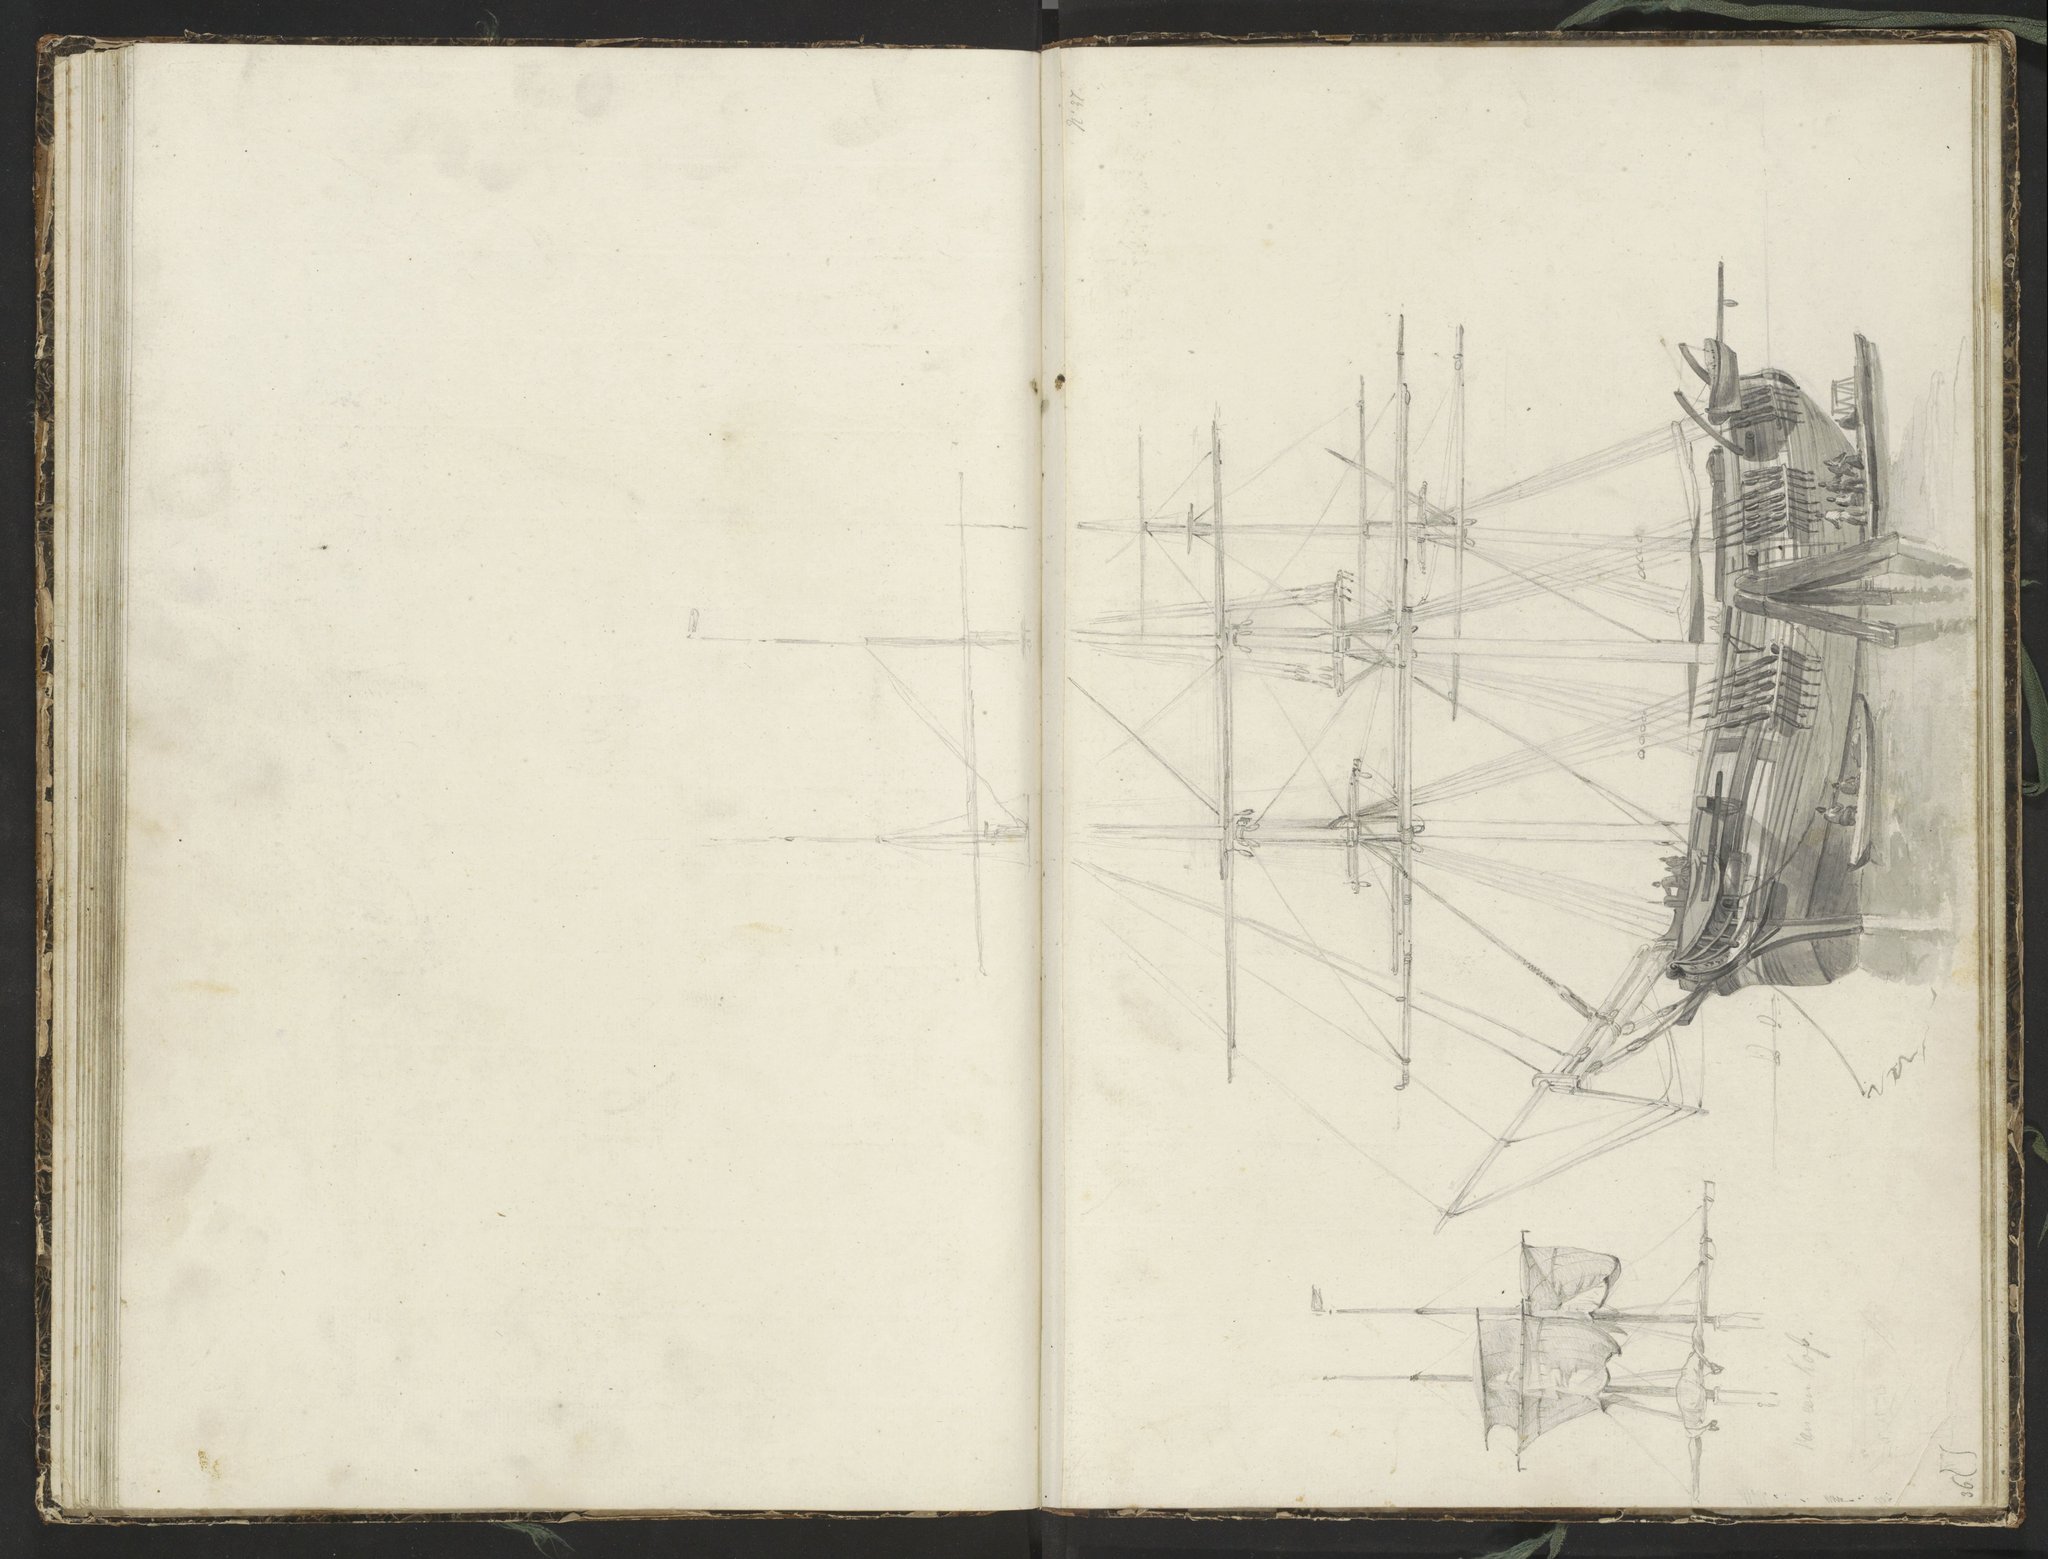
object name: sketchbook leaf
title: Driemaster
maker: johannes christiaan schotel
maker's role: draughtsman, painter, print maker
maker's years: 1787-1838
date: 1797-1838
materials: paper, pencil, watercolor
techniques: brush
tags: sailing-ship, sailing-boat, parts of ship's exterior: mast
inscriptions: annotation: ‘van een kop.’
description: Tevens een studie van twee masten met zeilen die ten dele gehesen zijn. Blad 35 verso en 36 recto uit een schetsboek met 44 bladen.